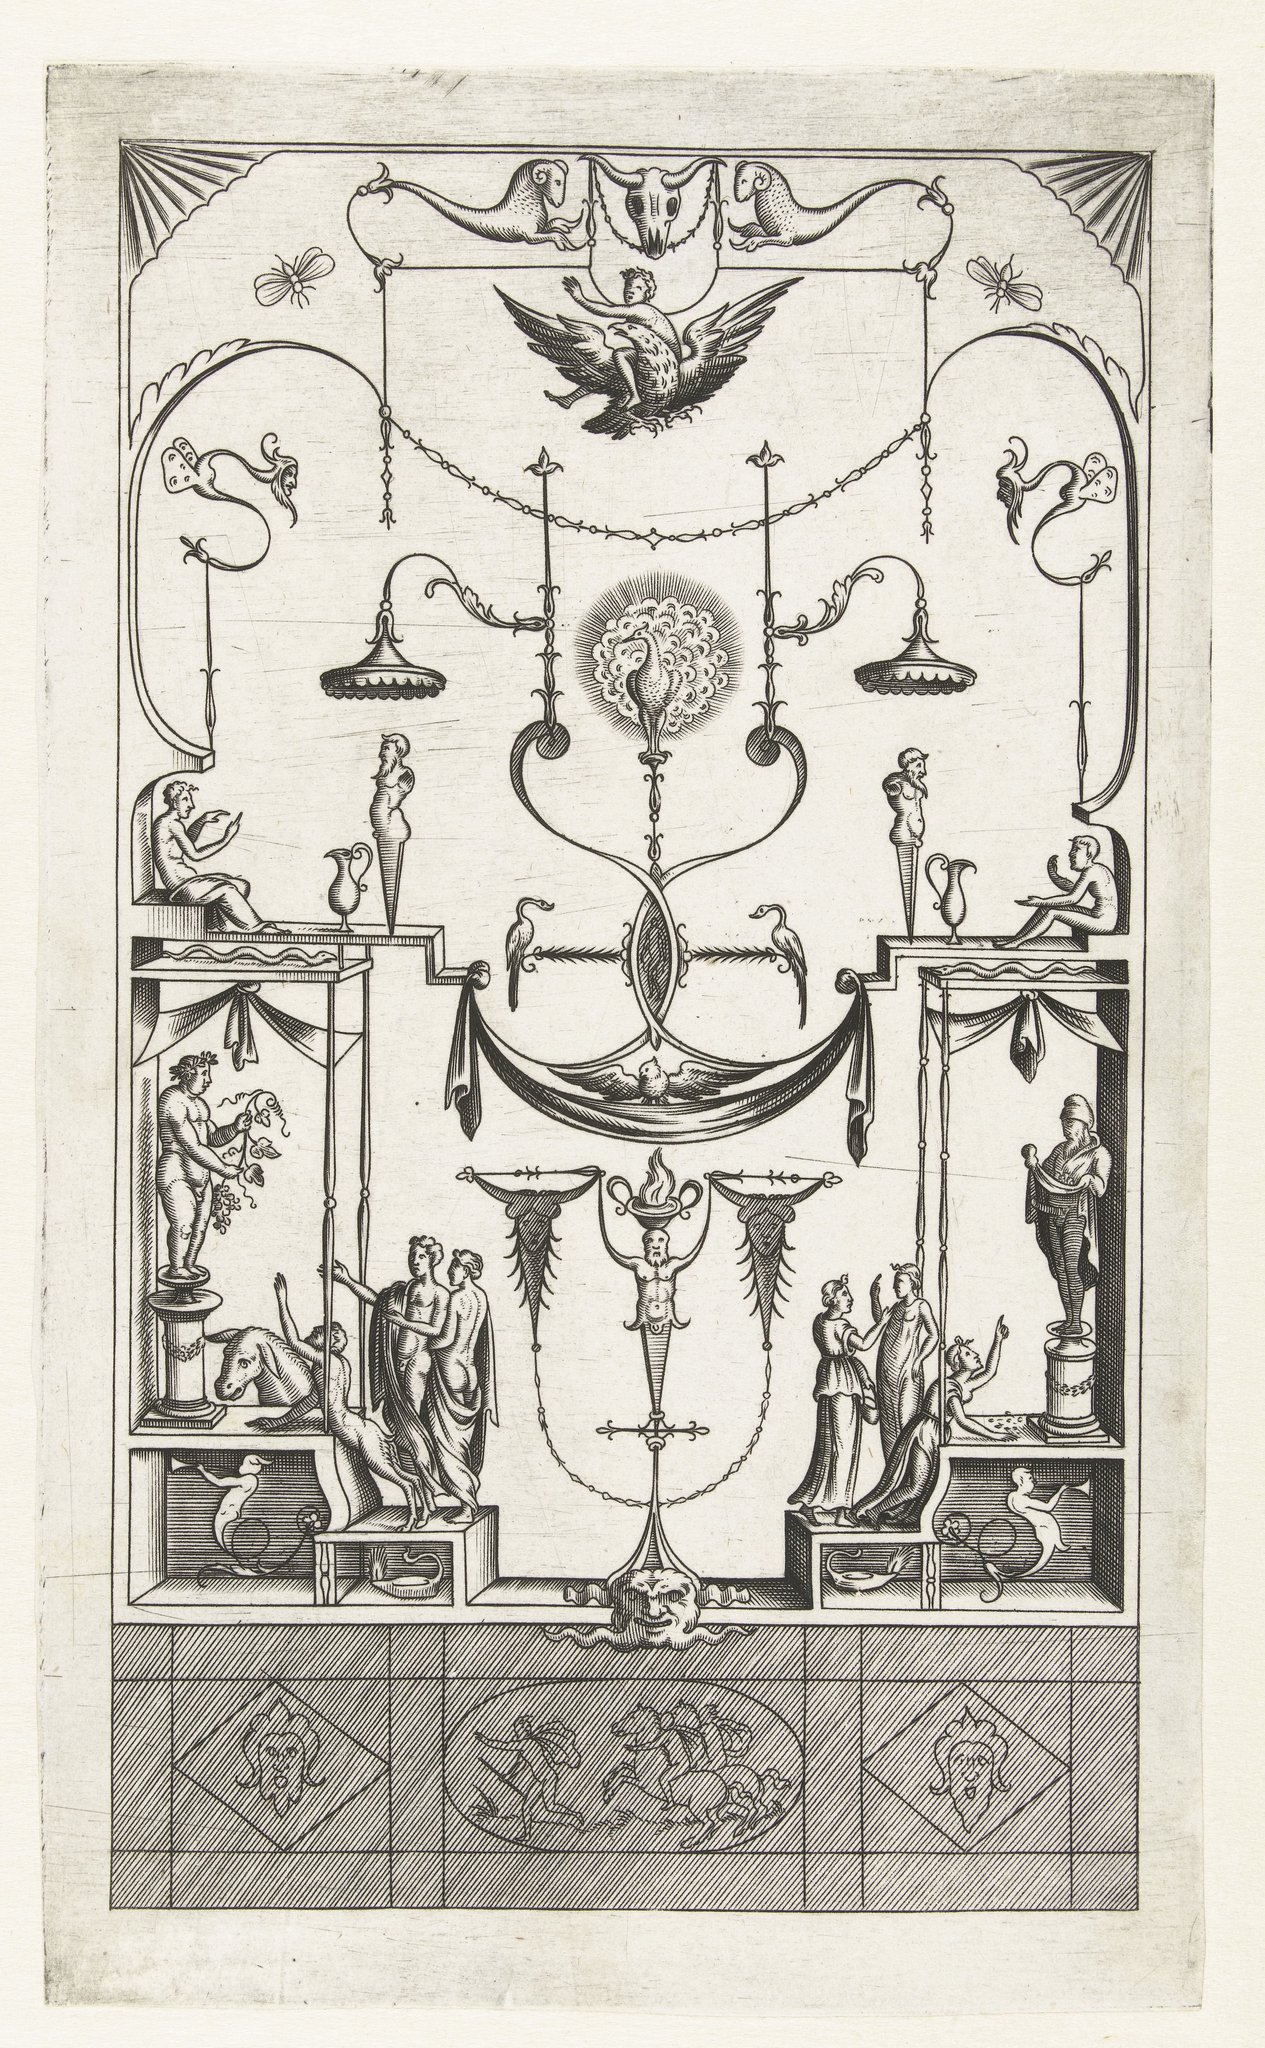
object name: print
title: Leviores et ut videtur extemporaneae picturae quas grotteschas vulgo vocant (...)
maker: Anonymous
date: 1530-1540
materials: paper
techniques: engraving, etching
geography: italy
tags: the rape of ganymede: he is carried off through the air by jupiter in the form of an eagle, or by the eagle of jupiter, ornament derived from architectural details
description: Vlakdecoratie met archtectuurfantasie en grotesken. Links Bacchus en rechts Priapus onder een baldakijn op een ronde sokkel, aanbeden door verschillende figuren. In het bovenste gedeelte saters en hermen. Uit serie van 20 bladen.